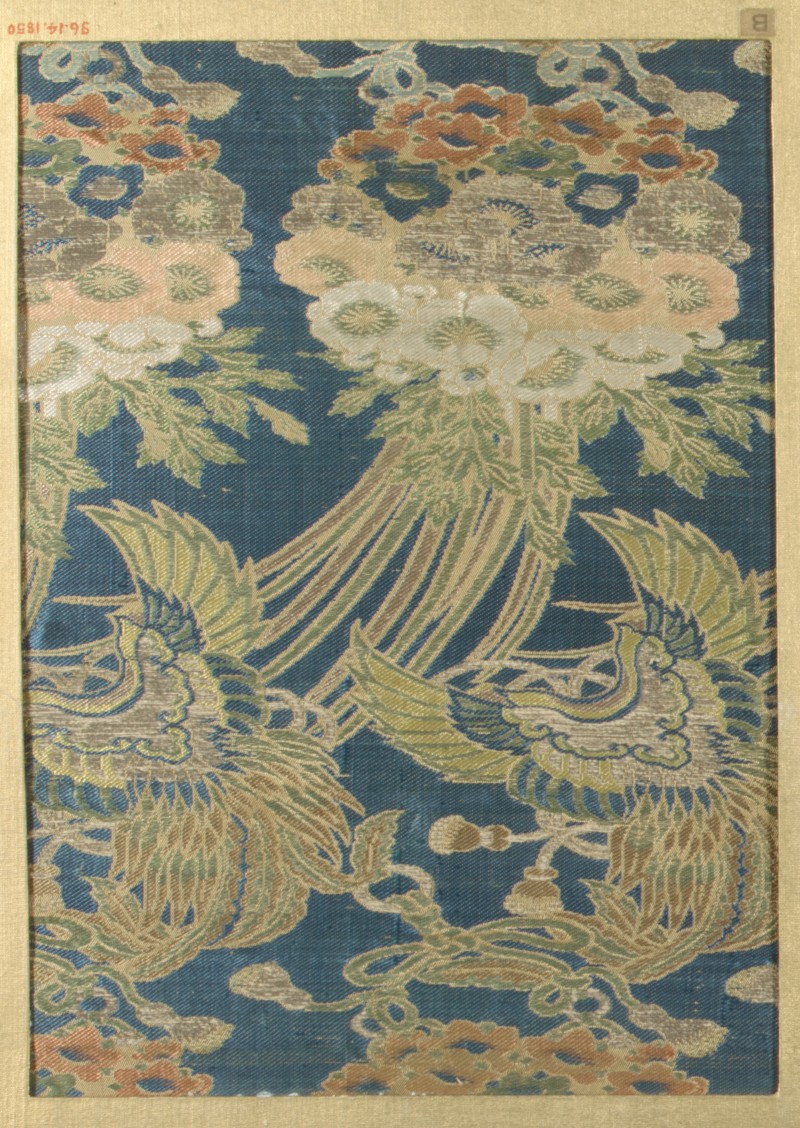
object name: piece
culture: japanese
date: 1701-1900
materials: silk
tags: leaves